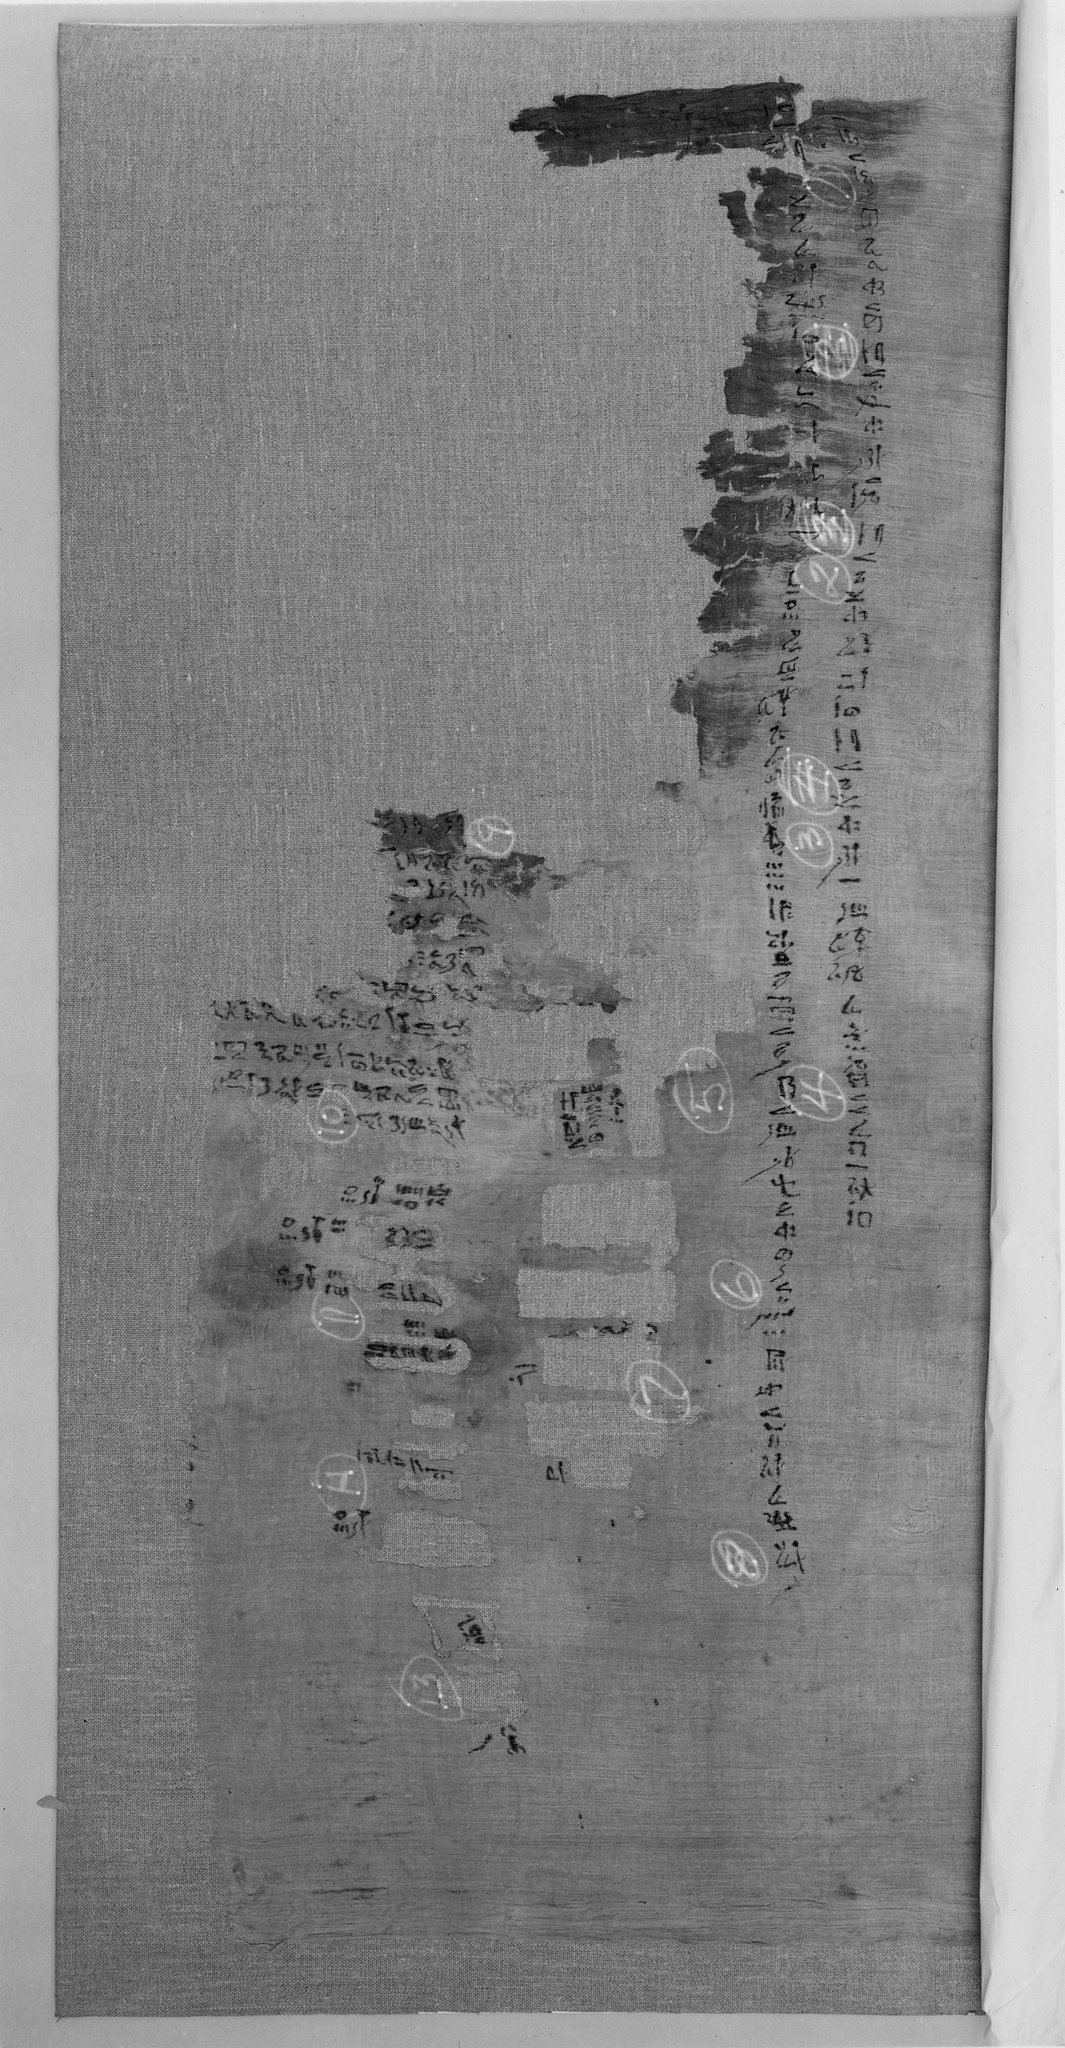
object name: shroud, ahmose penhet, son of ahhotep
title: Shroud of Ahmose Penhet, Son of Ahhotep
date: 1580-1479 BCE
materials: linen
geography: egypt